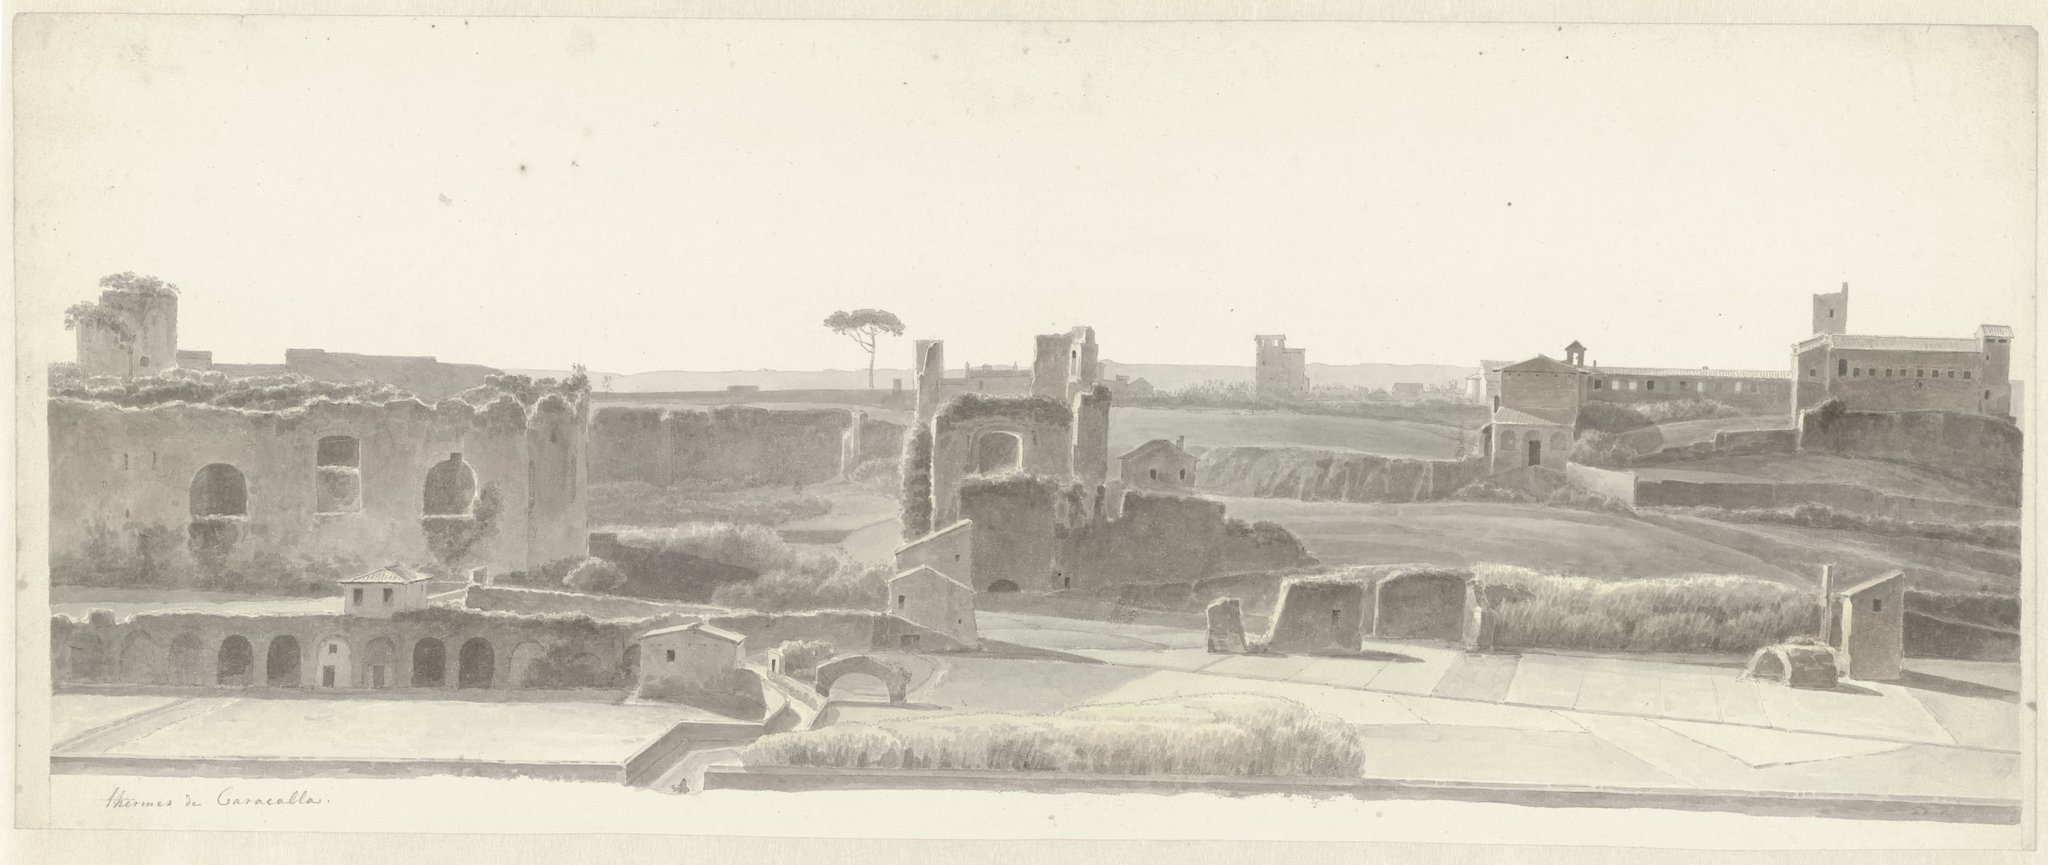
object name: drawing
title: The Baths of Caracalla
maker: josephus augustus knip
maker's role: draughtsman, painter, print maker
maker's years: 1777-1847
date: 1809-1812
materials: graphite, paper, watercolor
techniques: brush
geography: italy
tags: ruin of a building ~ architecture, landscape with ruins, rome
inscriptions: inscription: ‘thermes de Caracalla.’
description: Knip originally drew his spectacular panorama of the Baths of Caracalla, the largest and most luxurious of ancient Rome’s public baths, on three sheets of paper (now in five fragments). In Knip’s day, much of the complex still lay partially underground. The ruins were excavated from 1824, a process that continued long into the 20th century.